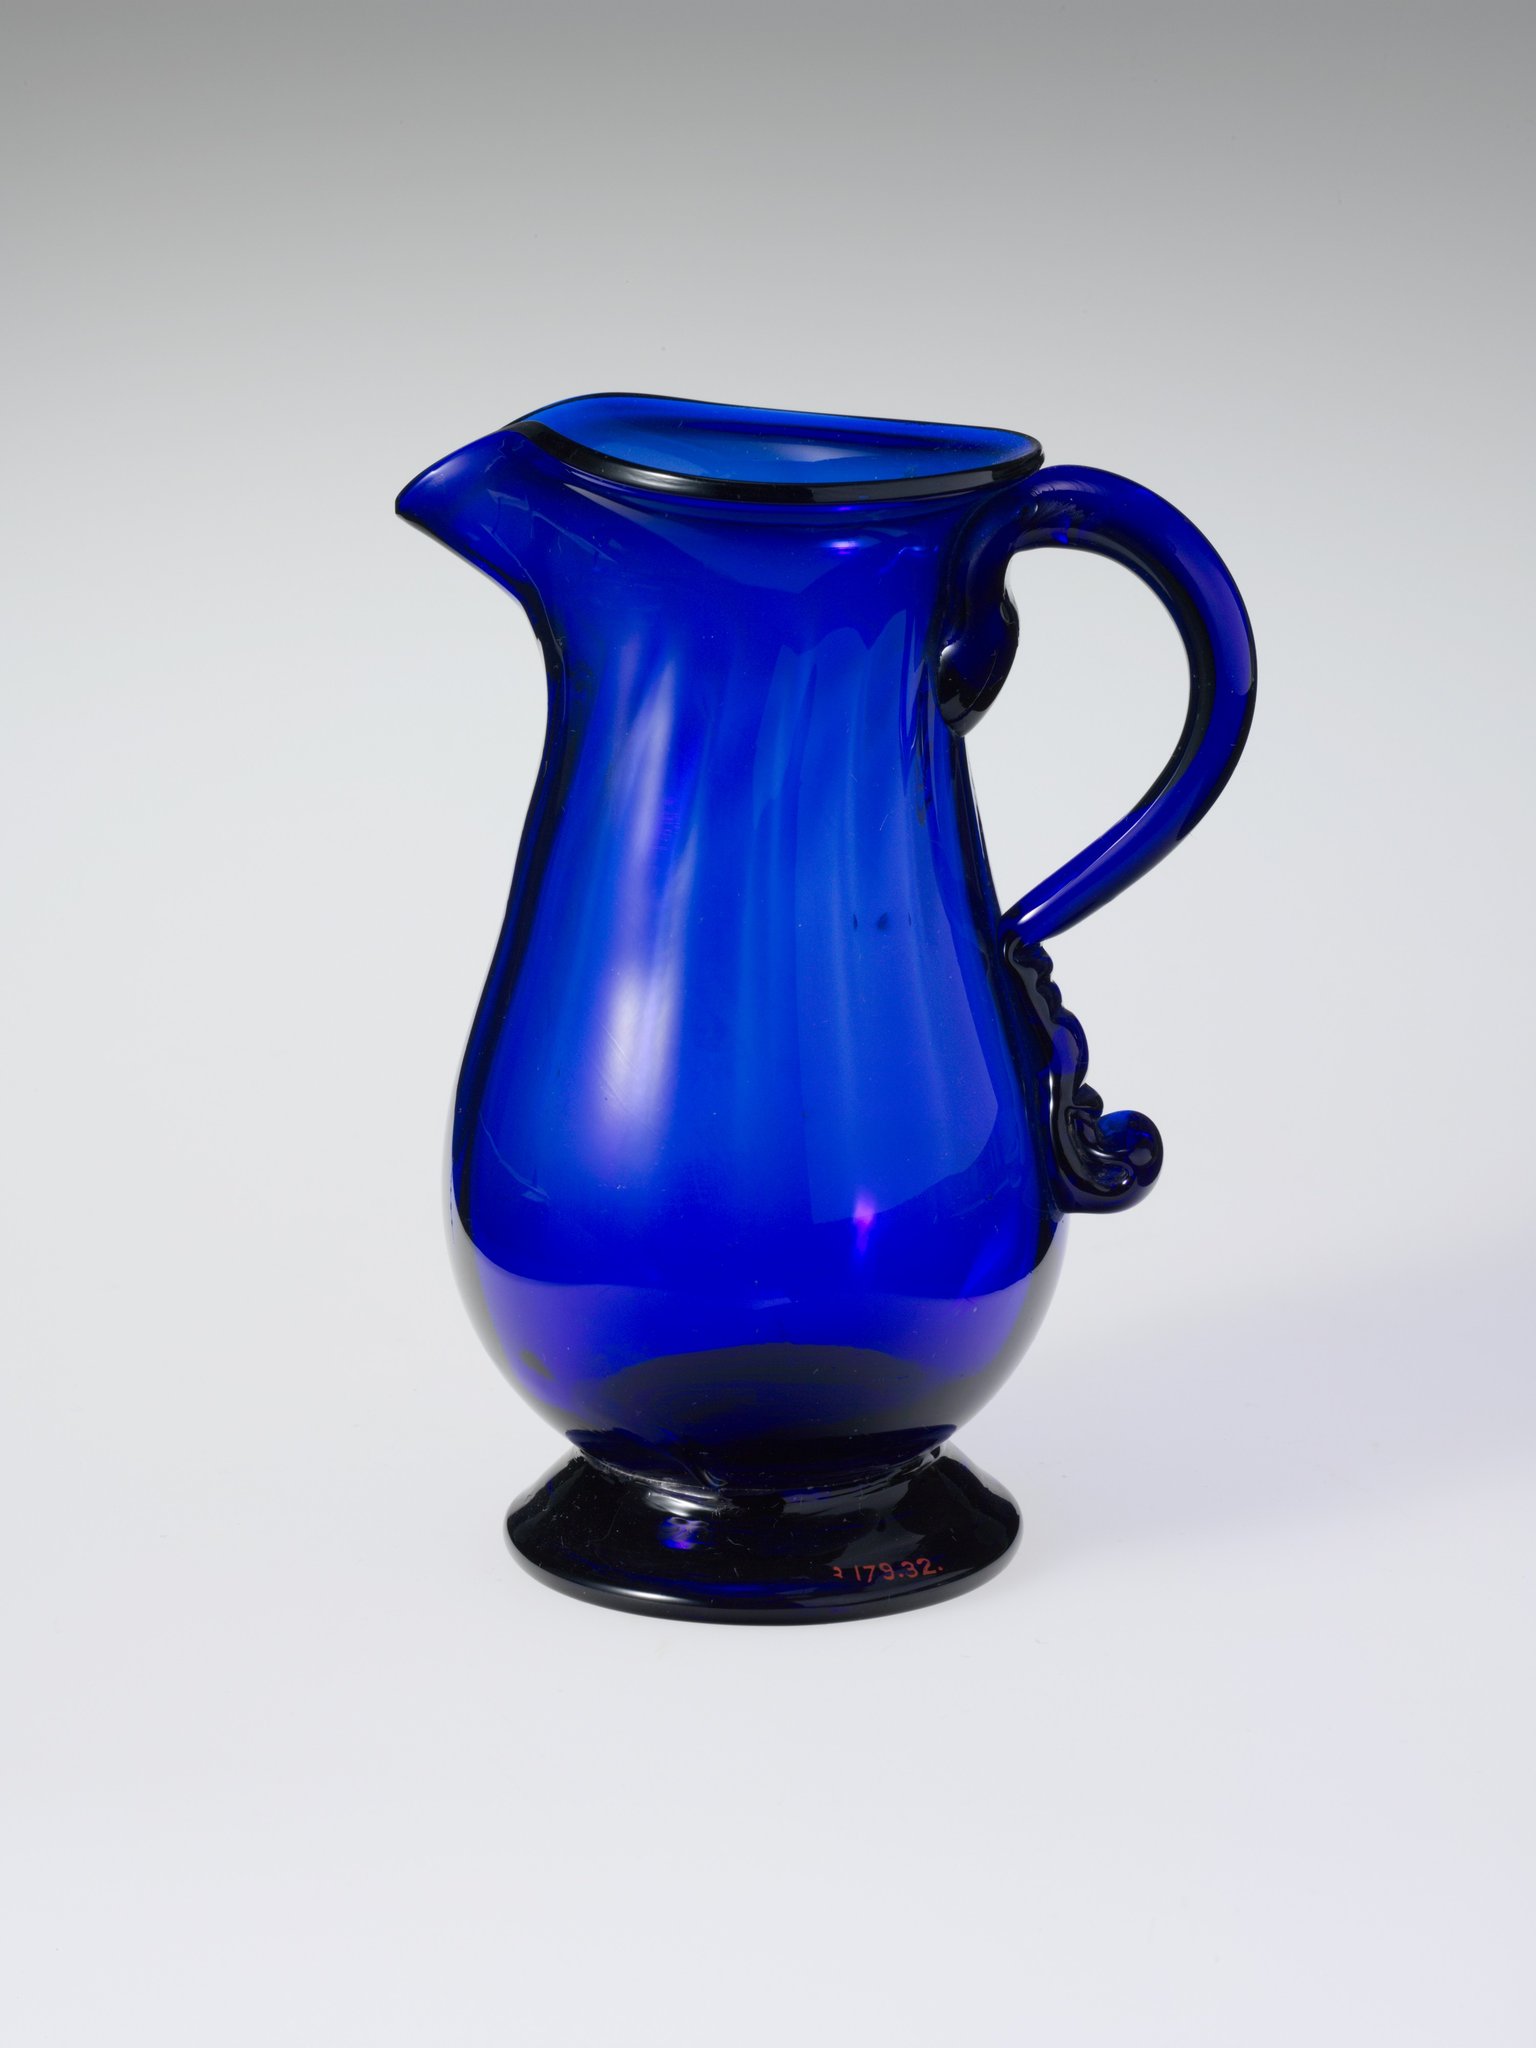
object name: cream jug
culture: american or british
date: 1780-1820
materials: glass, lead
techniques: glassblowing, molding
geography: england